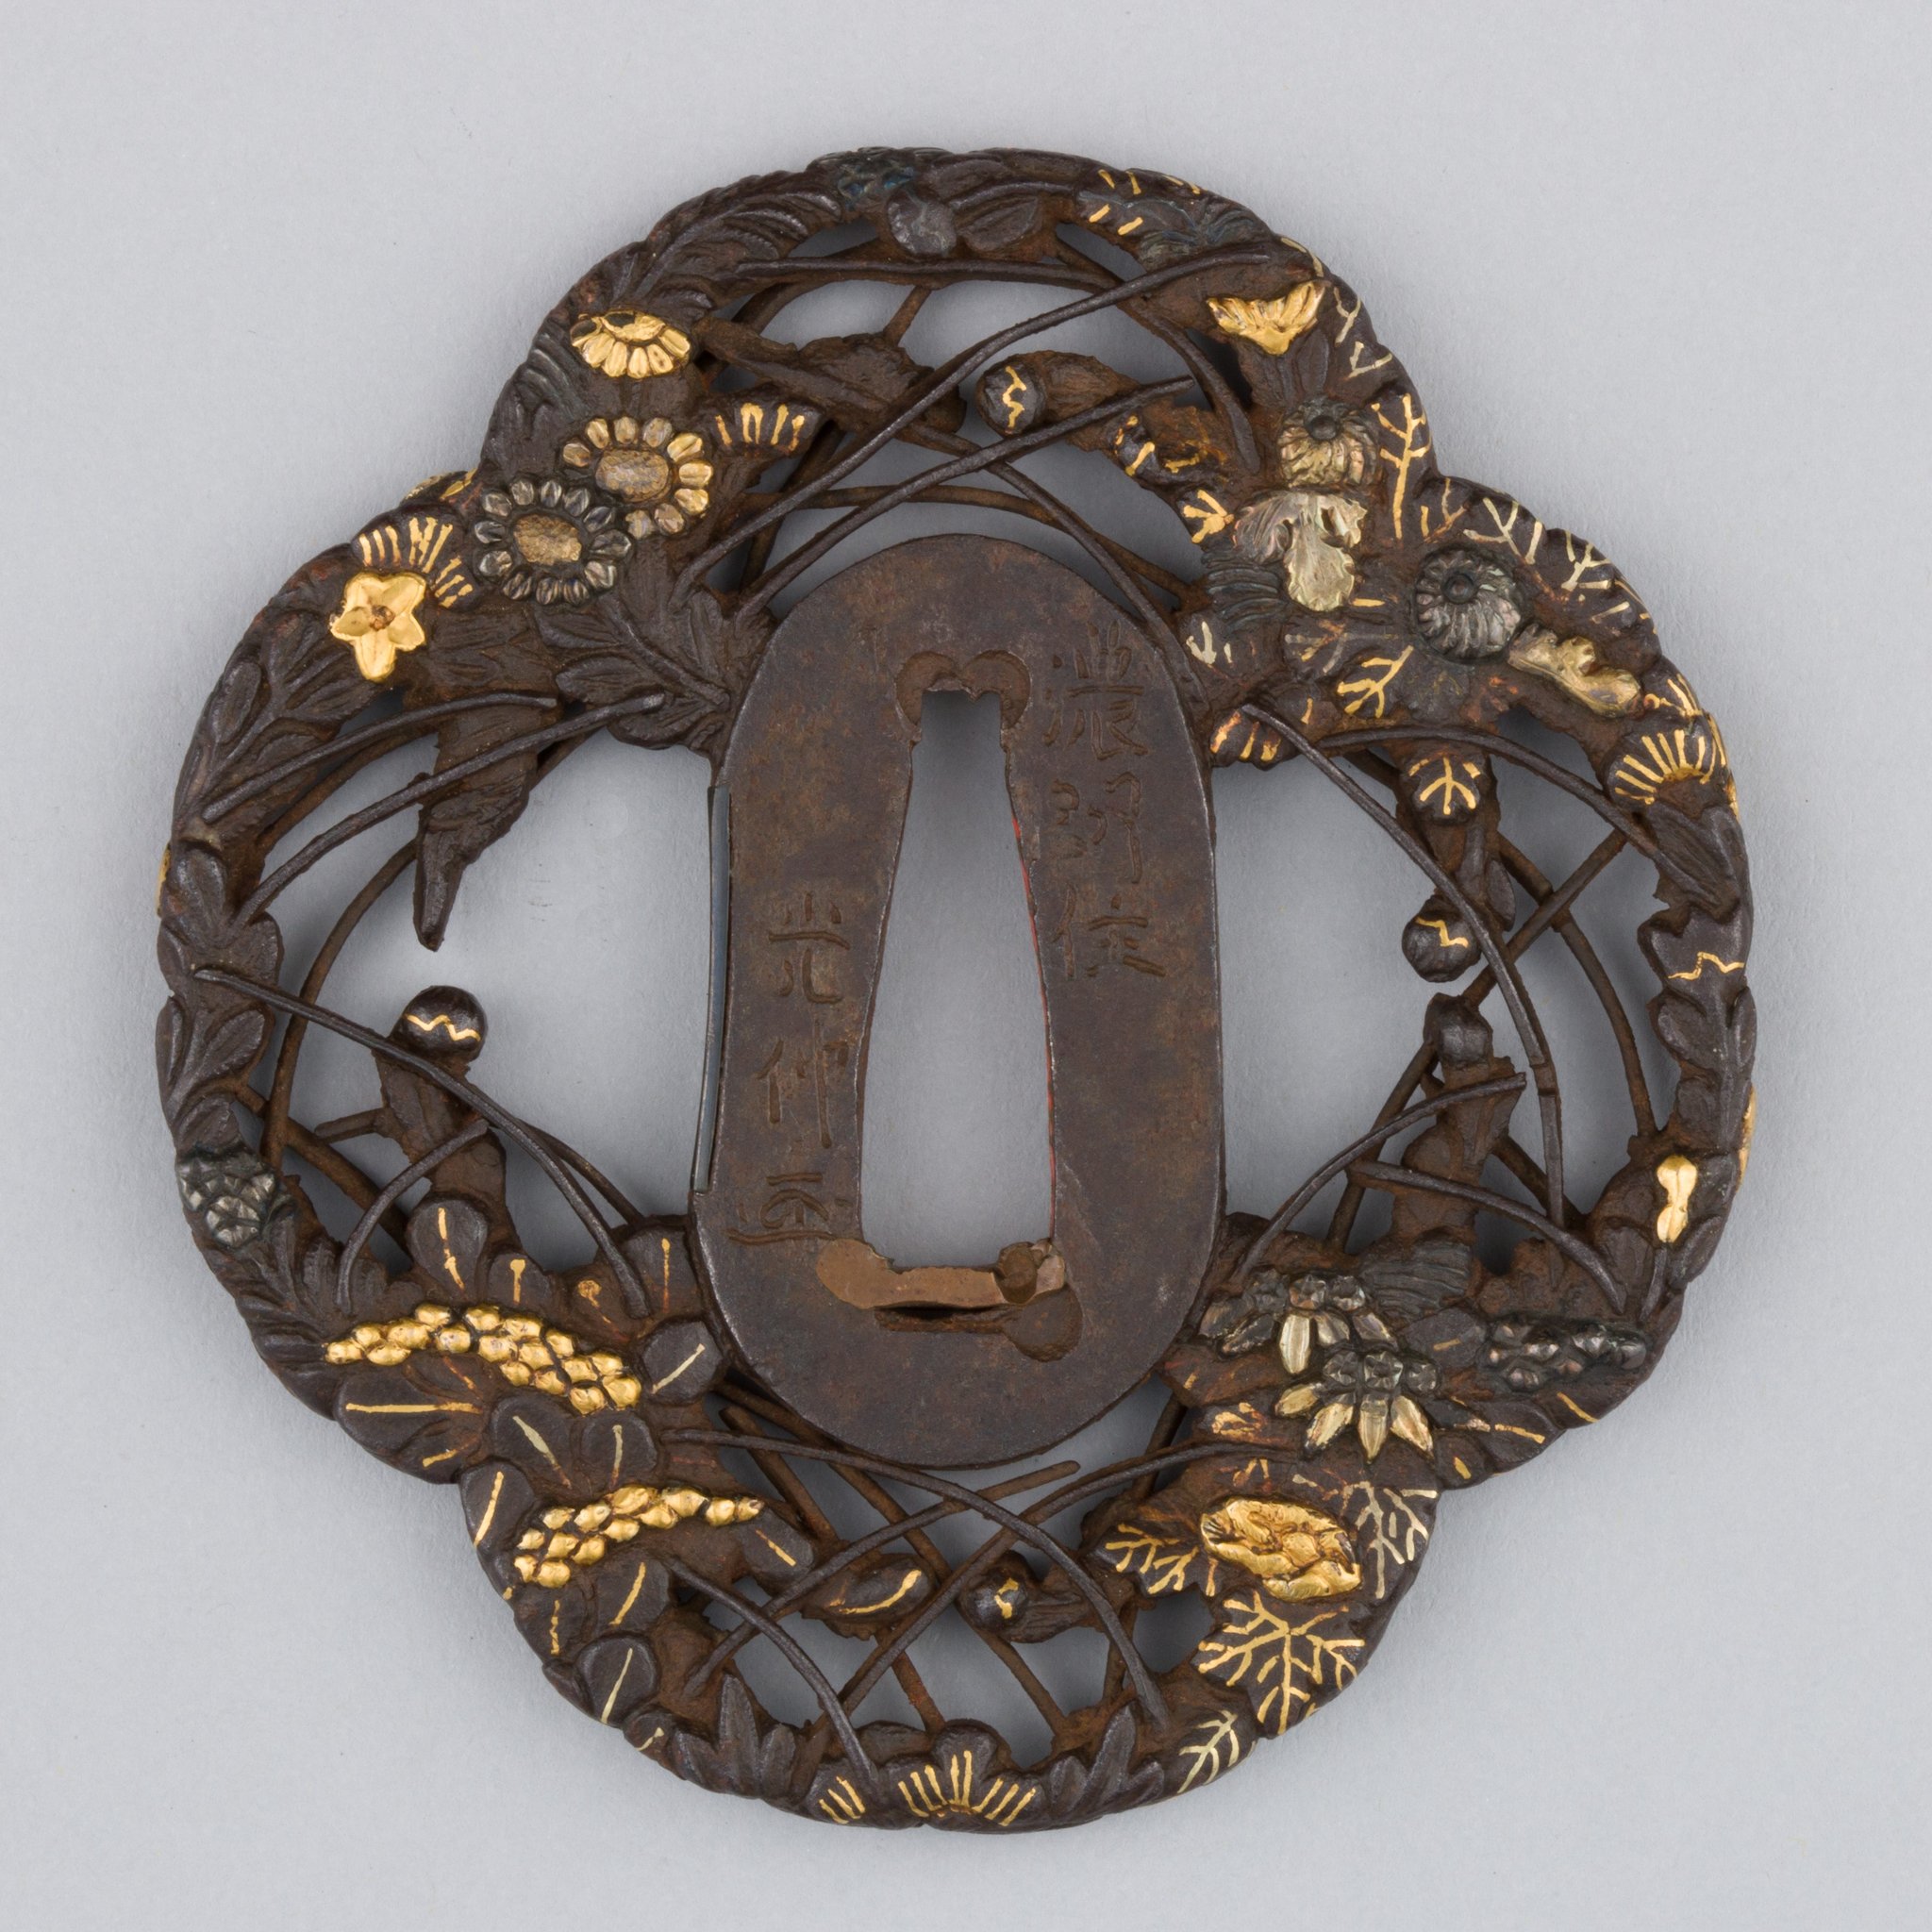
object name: sword guard tsuba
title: Sword Guard (Tsuba)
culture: japanese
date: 1615-1868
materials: copper, gold, iron, silver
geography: japan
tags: flowers